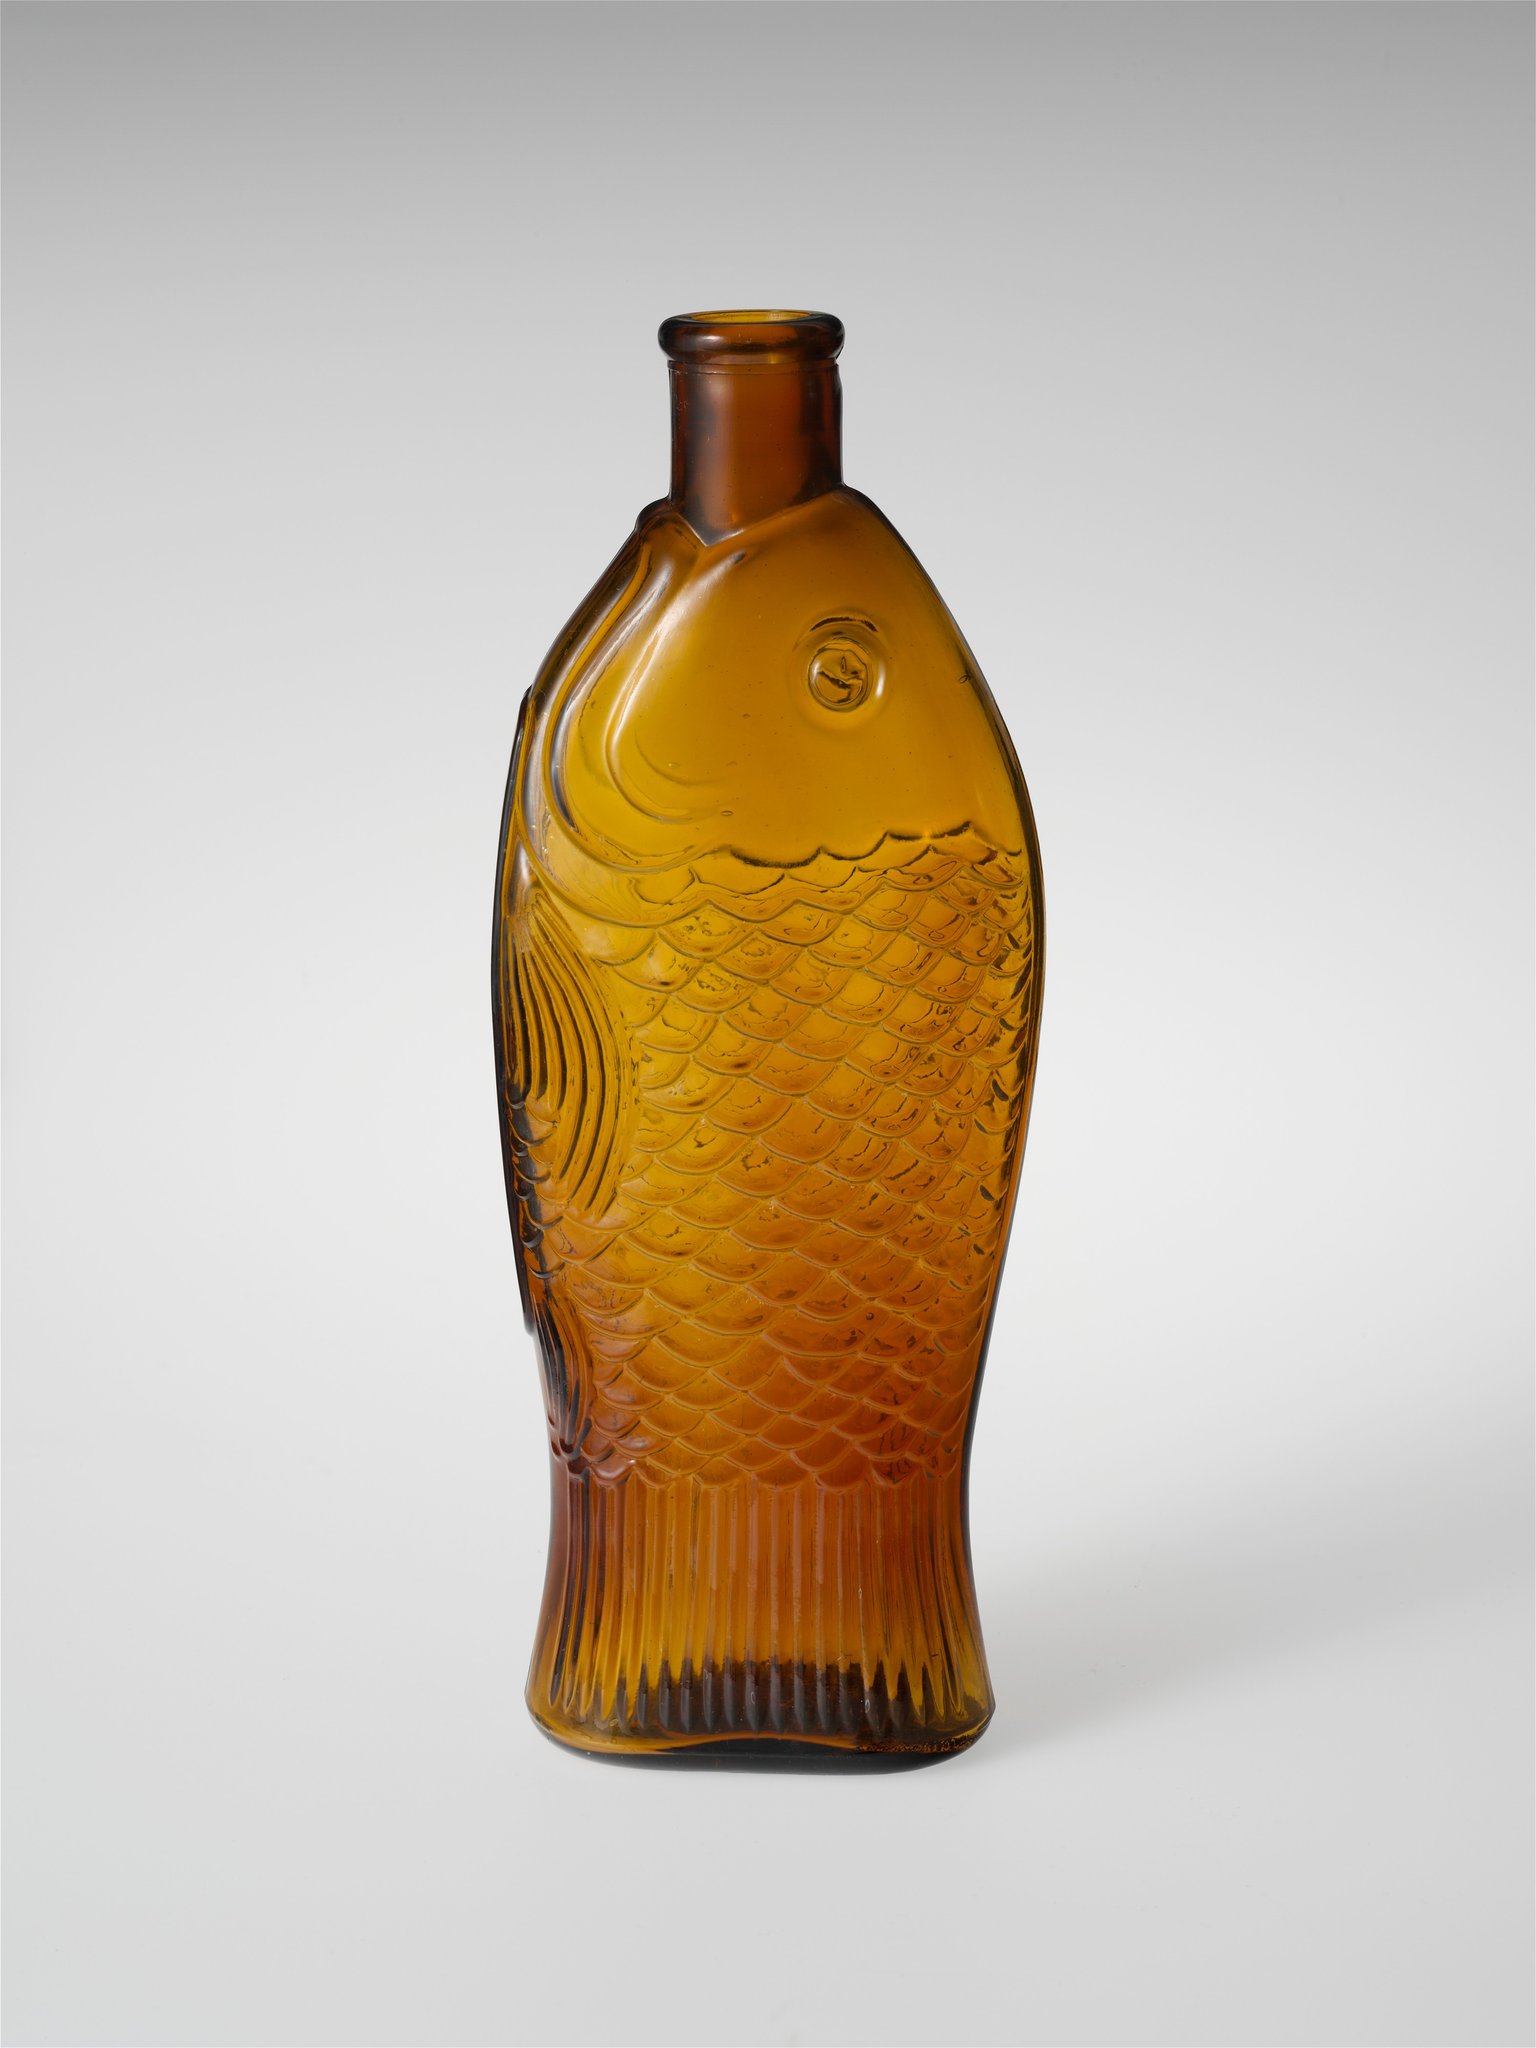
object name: bottle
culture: american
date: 1850-1900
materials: amber, glass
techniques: glassblowing, molding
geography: united states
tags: fish